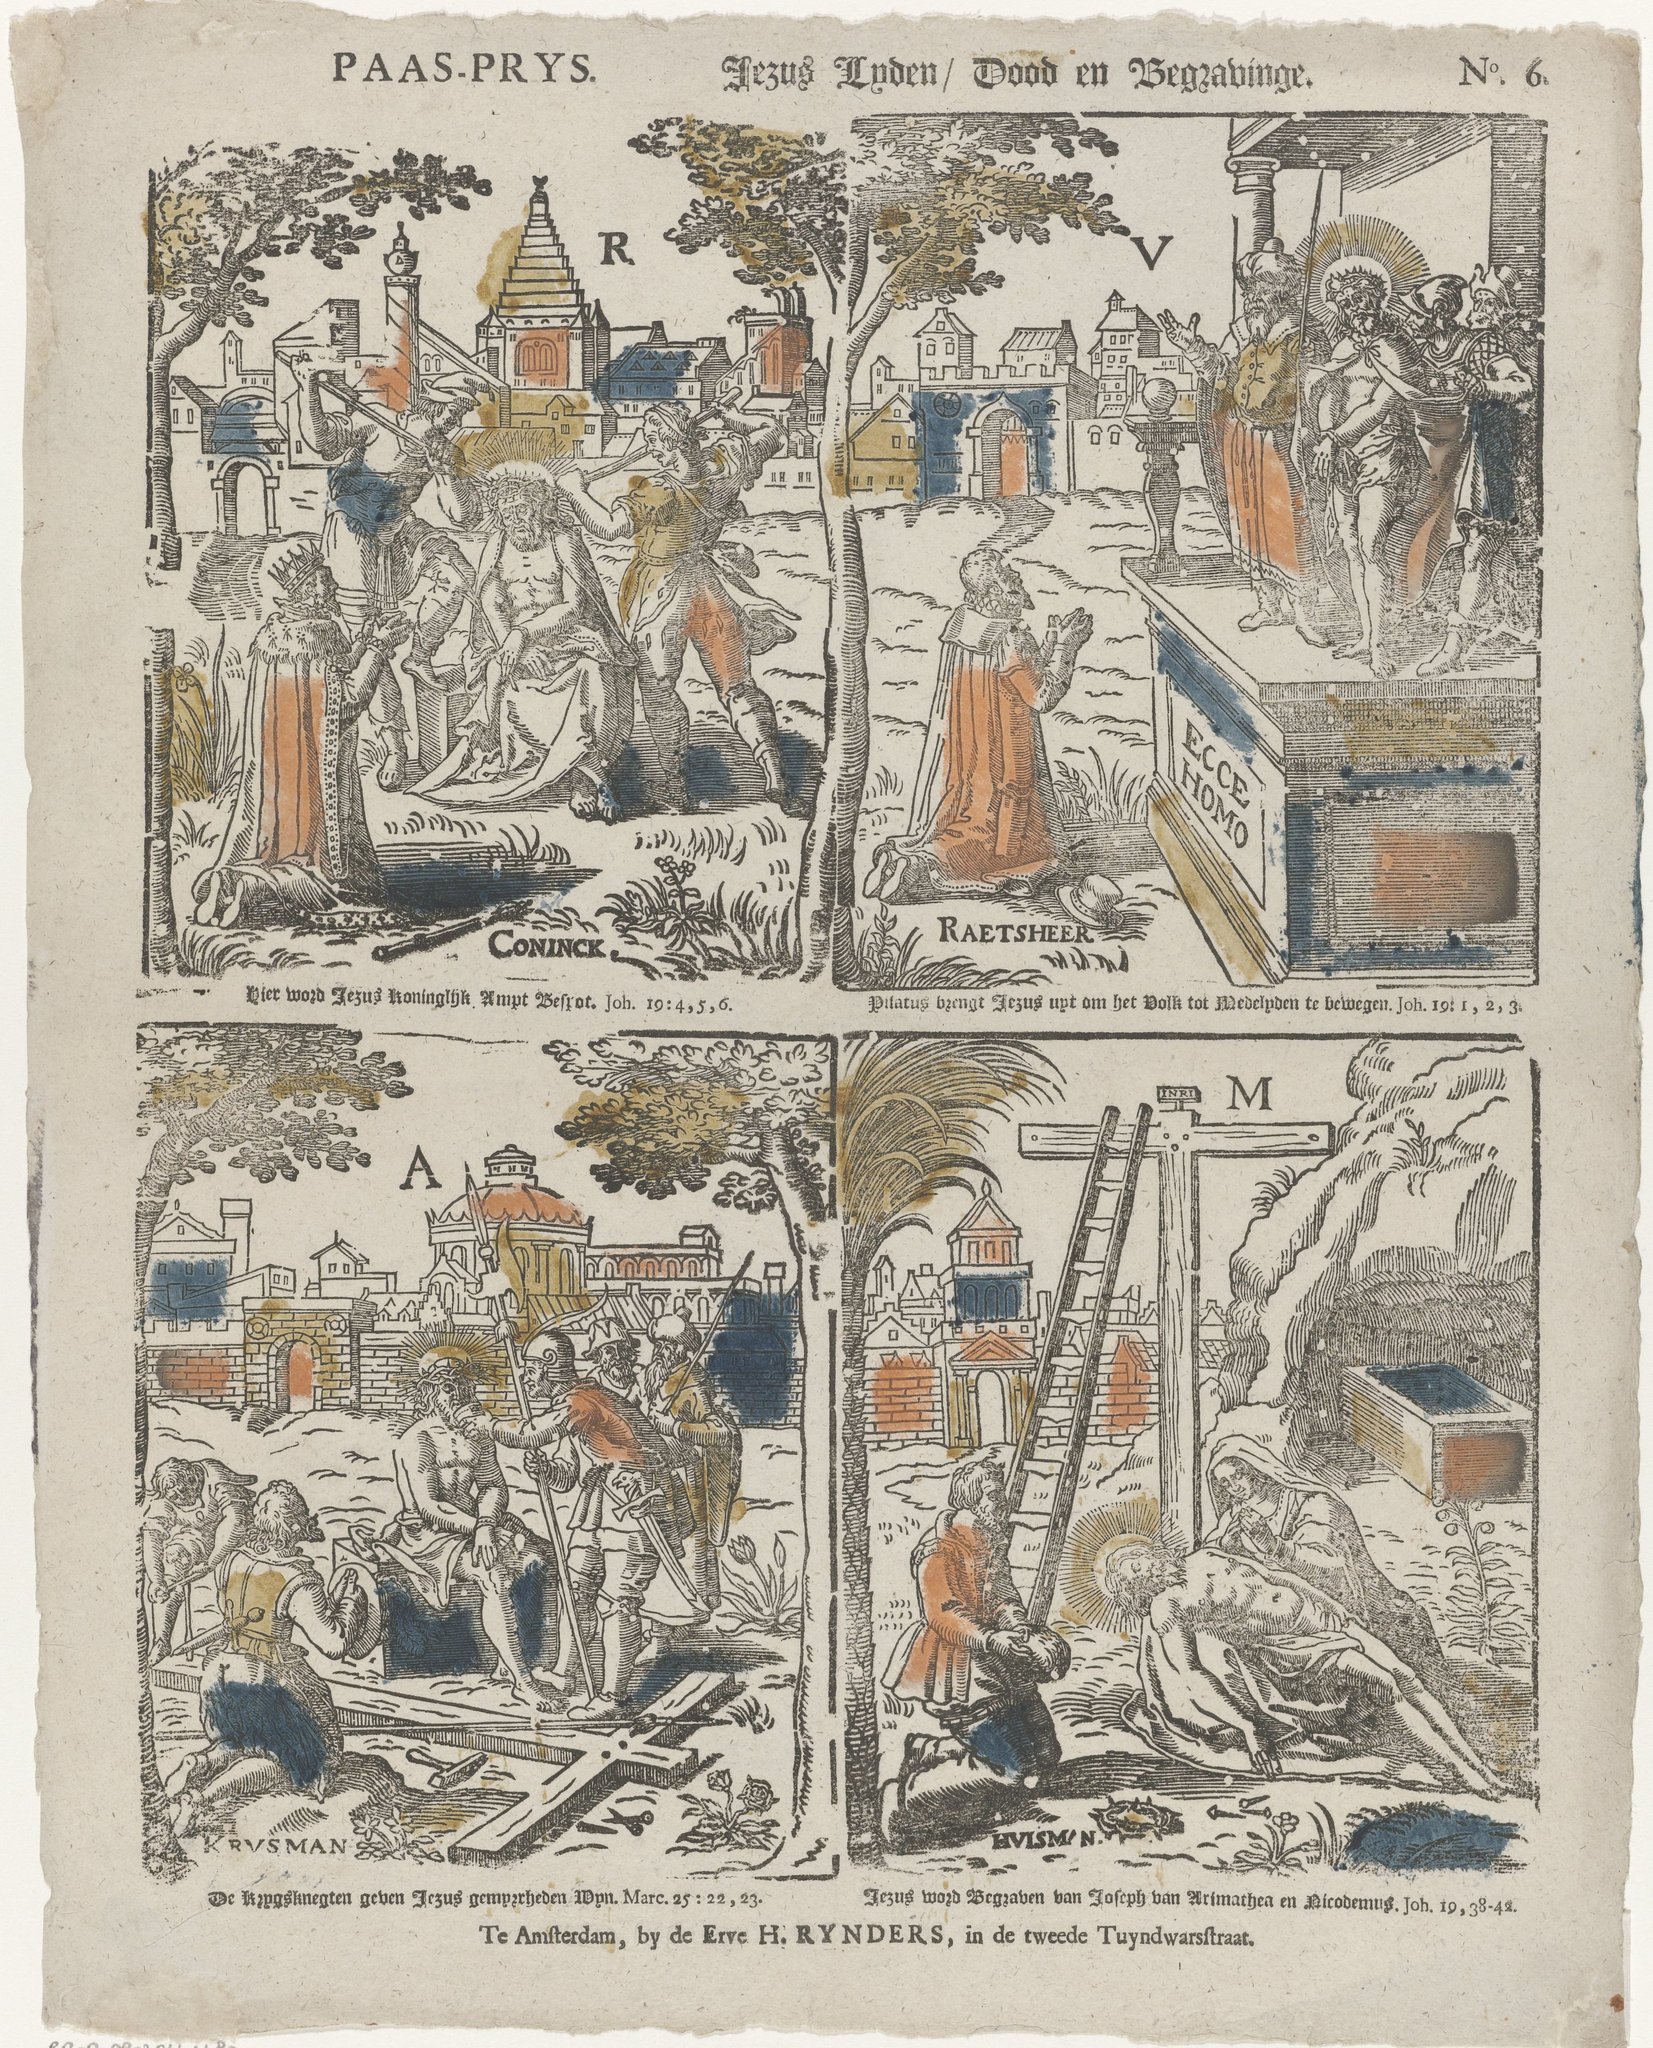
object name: print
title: Paas-prys / Jezus lyden / dood en begravinge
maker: Anonymous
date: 1831-1854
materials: paper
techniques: colour, letterpress printing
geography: netherlands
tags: christ's body supported by mary, others present, christ is offered a benumbing drink, but he refuses it, the empty cross(es), pilate showing christ to the people, 'ostentatio christi', 'ecce homo' (john 19:4-6), the crowning with thorns: soldiers with sticks place a thorny crown on christ's head and give him a reed (matthew 27:27-31; mark 15:16-20; john 19:2-3)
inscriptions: collector's mark: Lugt 2760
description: Blad met 4 voorstellingen uit het leven van Christus: de doornenkroning, Christus aan het volk getoond (Ecce Homo), Christus op de koude steen terwijl soldaten hem te drinken geven en de bewening van Christus met Maria en Nicodemus onder het kruis. Linksonder in elke afbeelding een knielende persoon met in boekdruk de tekst: Coninck / Raetsheer / Krysman / Hvisman. Midden boven in elke afbeelding een letter: R / V / A / M. Onder elke afbeelding een onderschrift en een verwijzing naar de bijbehorende Bijbeltekst. Genummerd rechtsboven: No. 6.